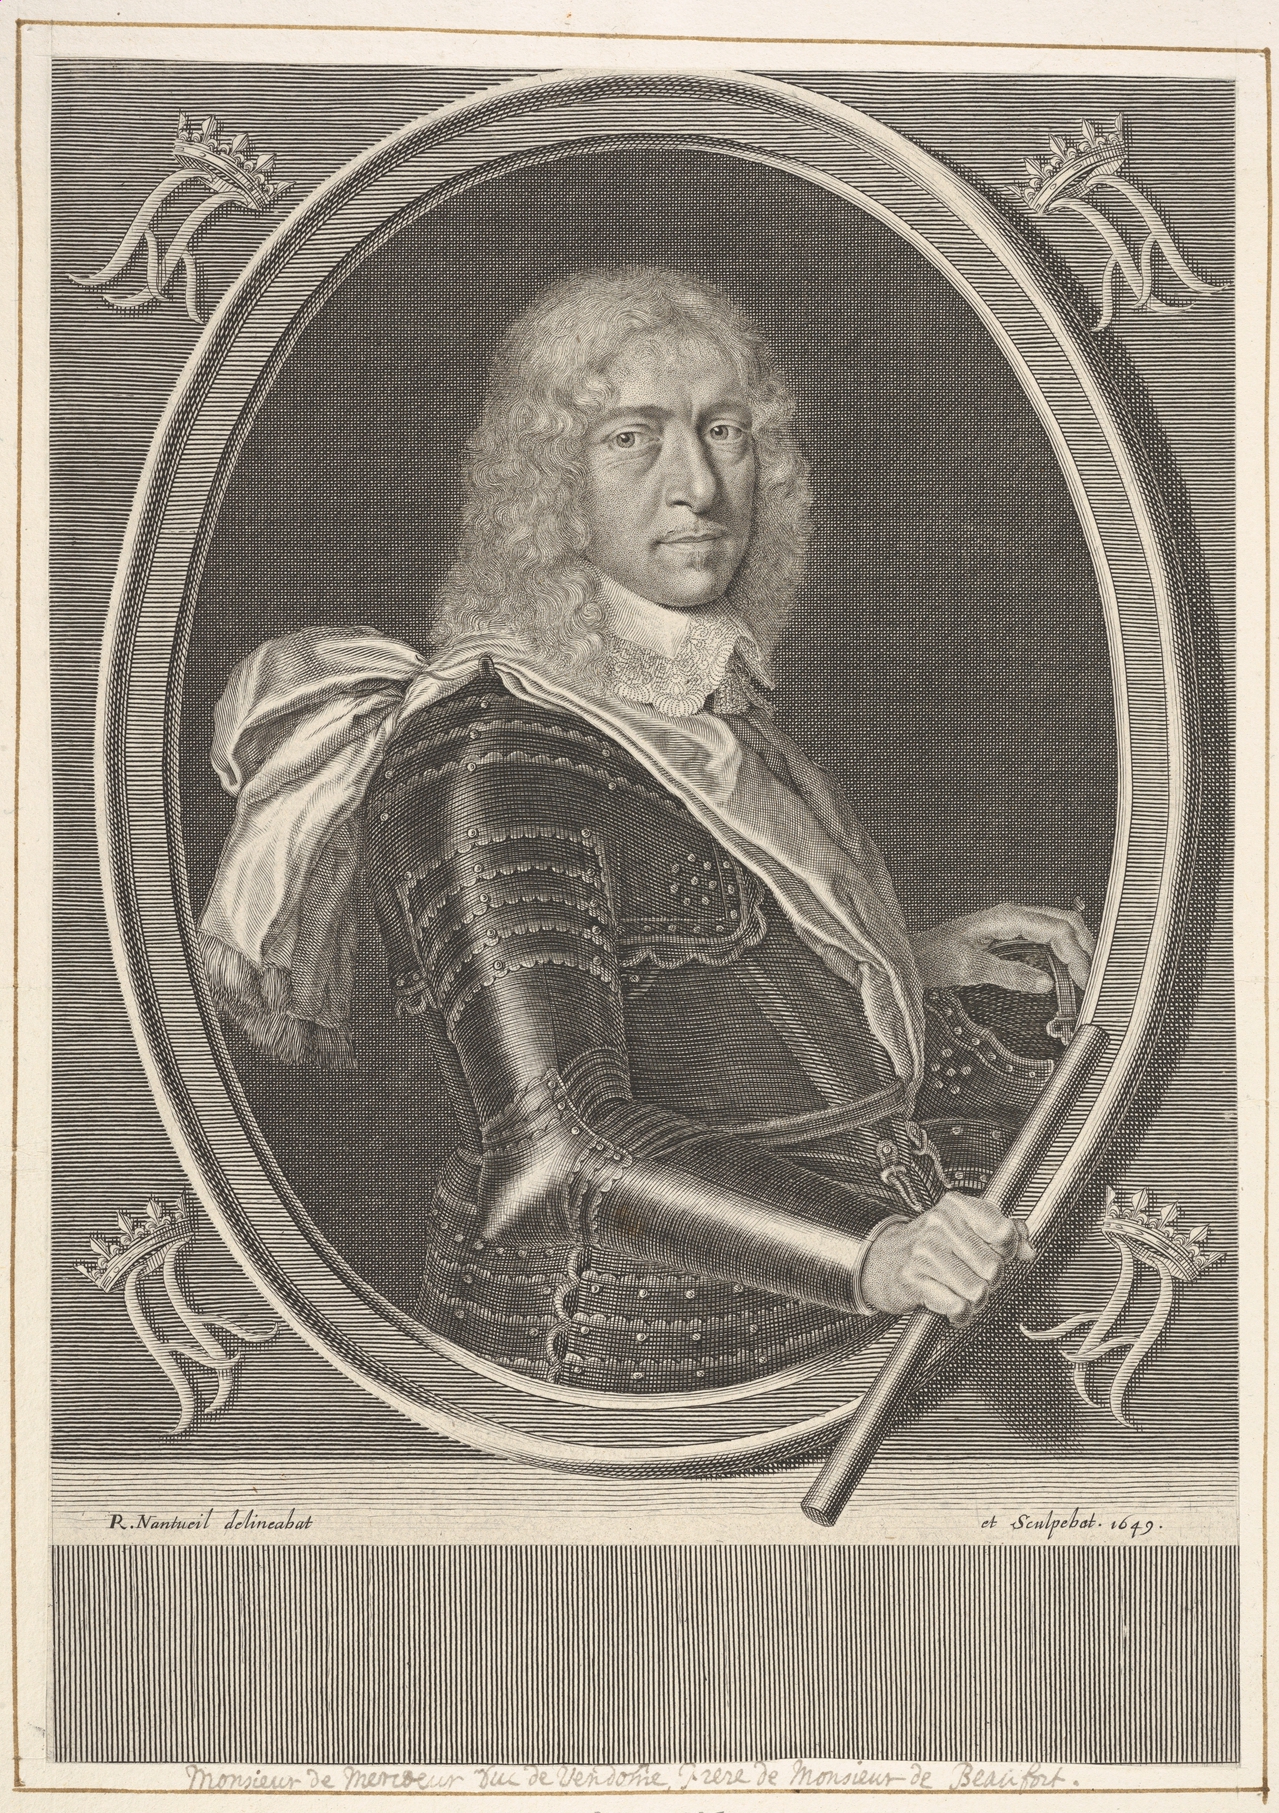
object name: print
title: Louis de Bourbon-Vendôme, duc de Mercoeur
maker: robert nanteuil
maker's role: artist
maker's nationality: french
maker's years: 1623-1678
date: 1649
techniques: engraving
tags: men,portraits